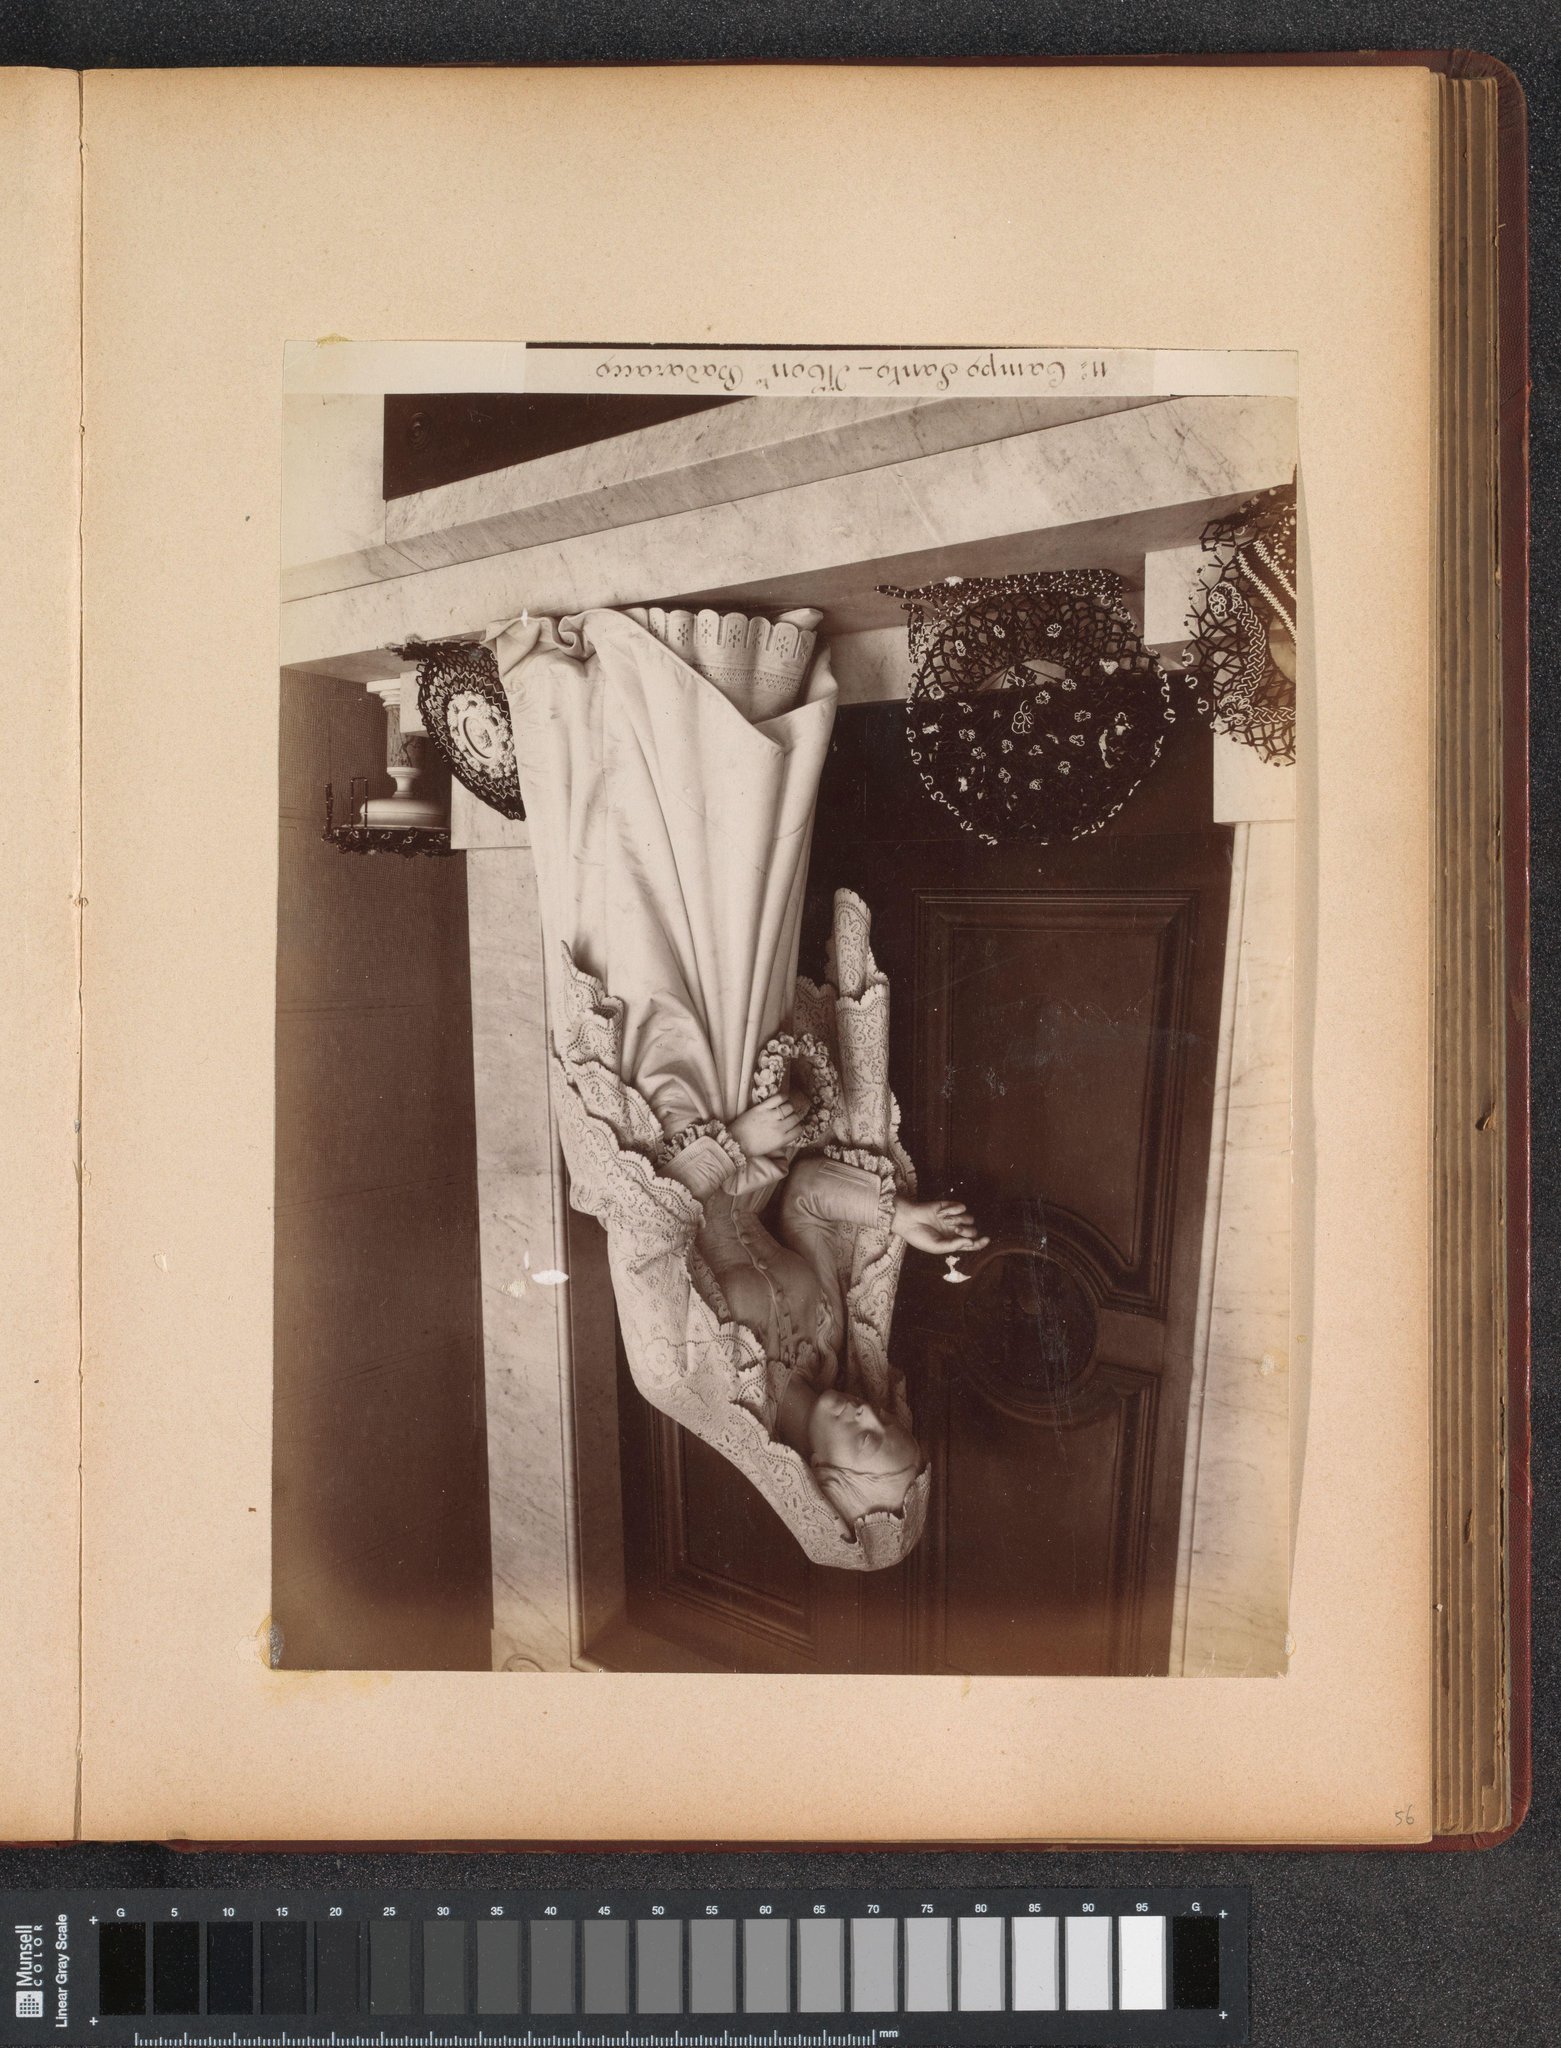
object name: album leaf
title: Campo Santo. Mon.to Badaracco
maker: Anonymous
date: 1870-1900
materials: paper, photographic support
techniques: albumen print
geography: genoa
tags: piece of sculpture, reproduction of a piece of sculpture (+ sculpture), grave-building, monumental tomb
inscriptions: negative number: ‘11’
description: Onderdeel van Reisalbum met foto's van bezienswaardigheden in Italië en Zuid-Frankrijk.